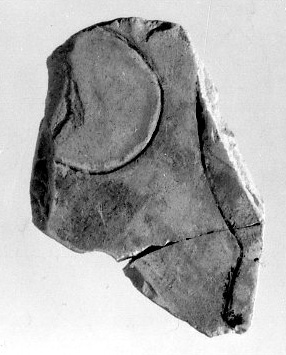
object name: relief fragment, tomb of meketre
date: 1981-1975 BCE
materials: limestone, paint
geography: egypt